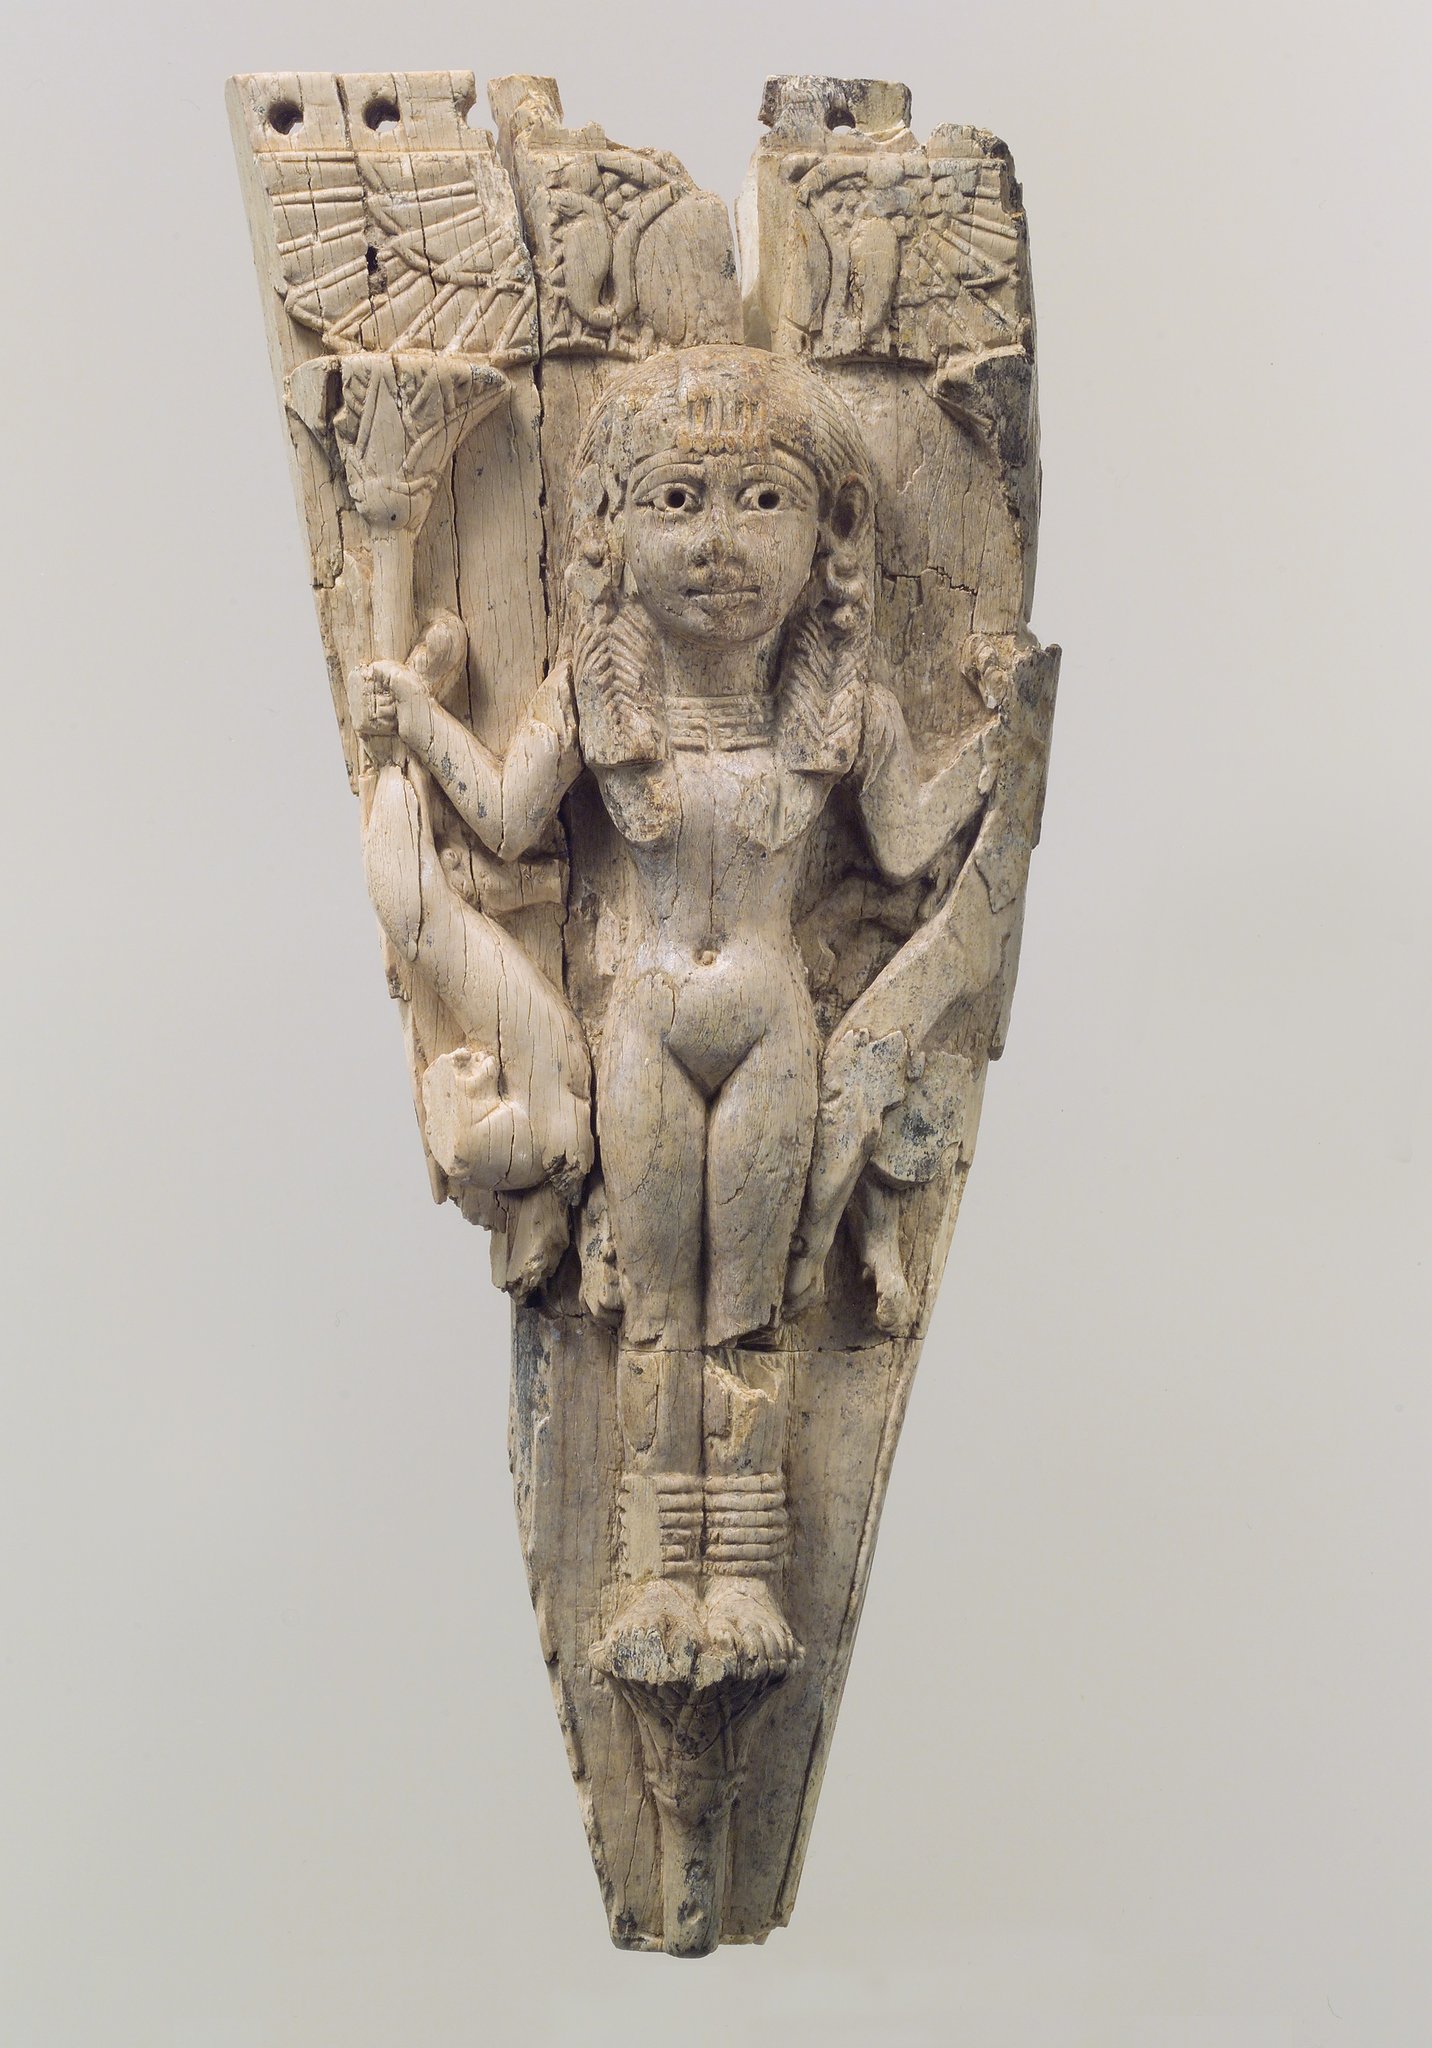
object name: horse frontlet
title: Horse frontlet carved in relief with a female figure flanked by lions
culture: assyrian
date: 900-701 BCE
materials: ivory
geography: mesopotamia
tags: women,lions,lotuses